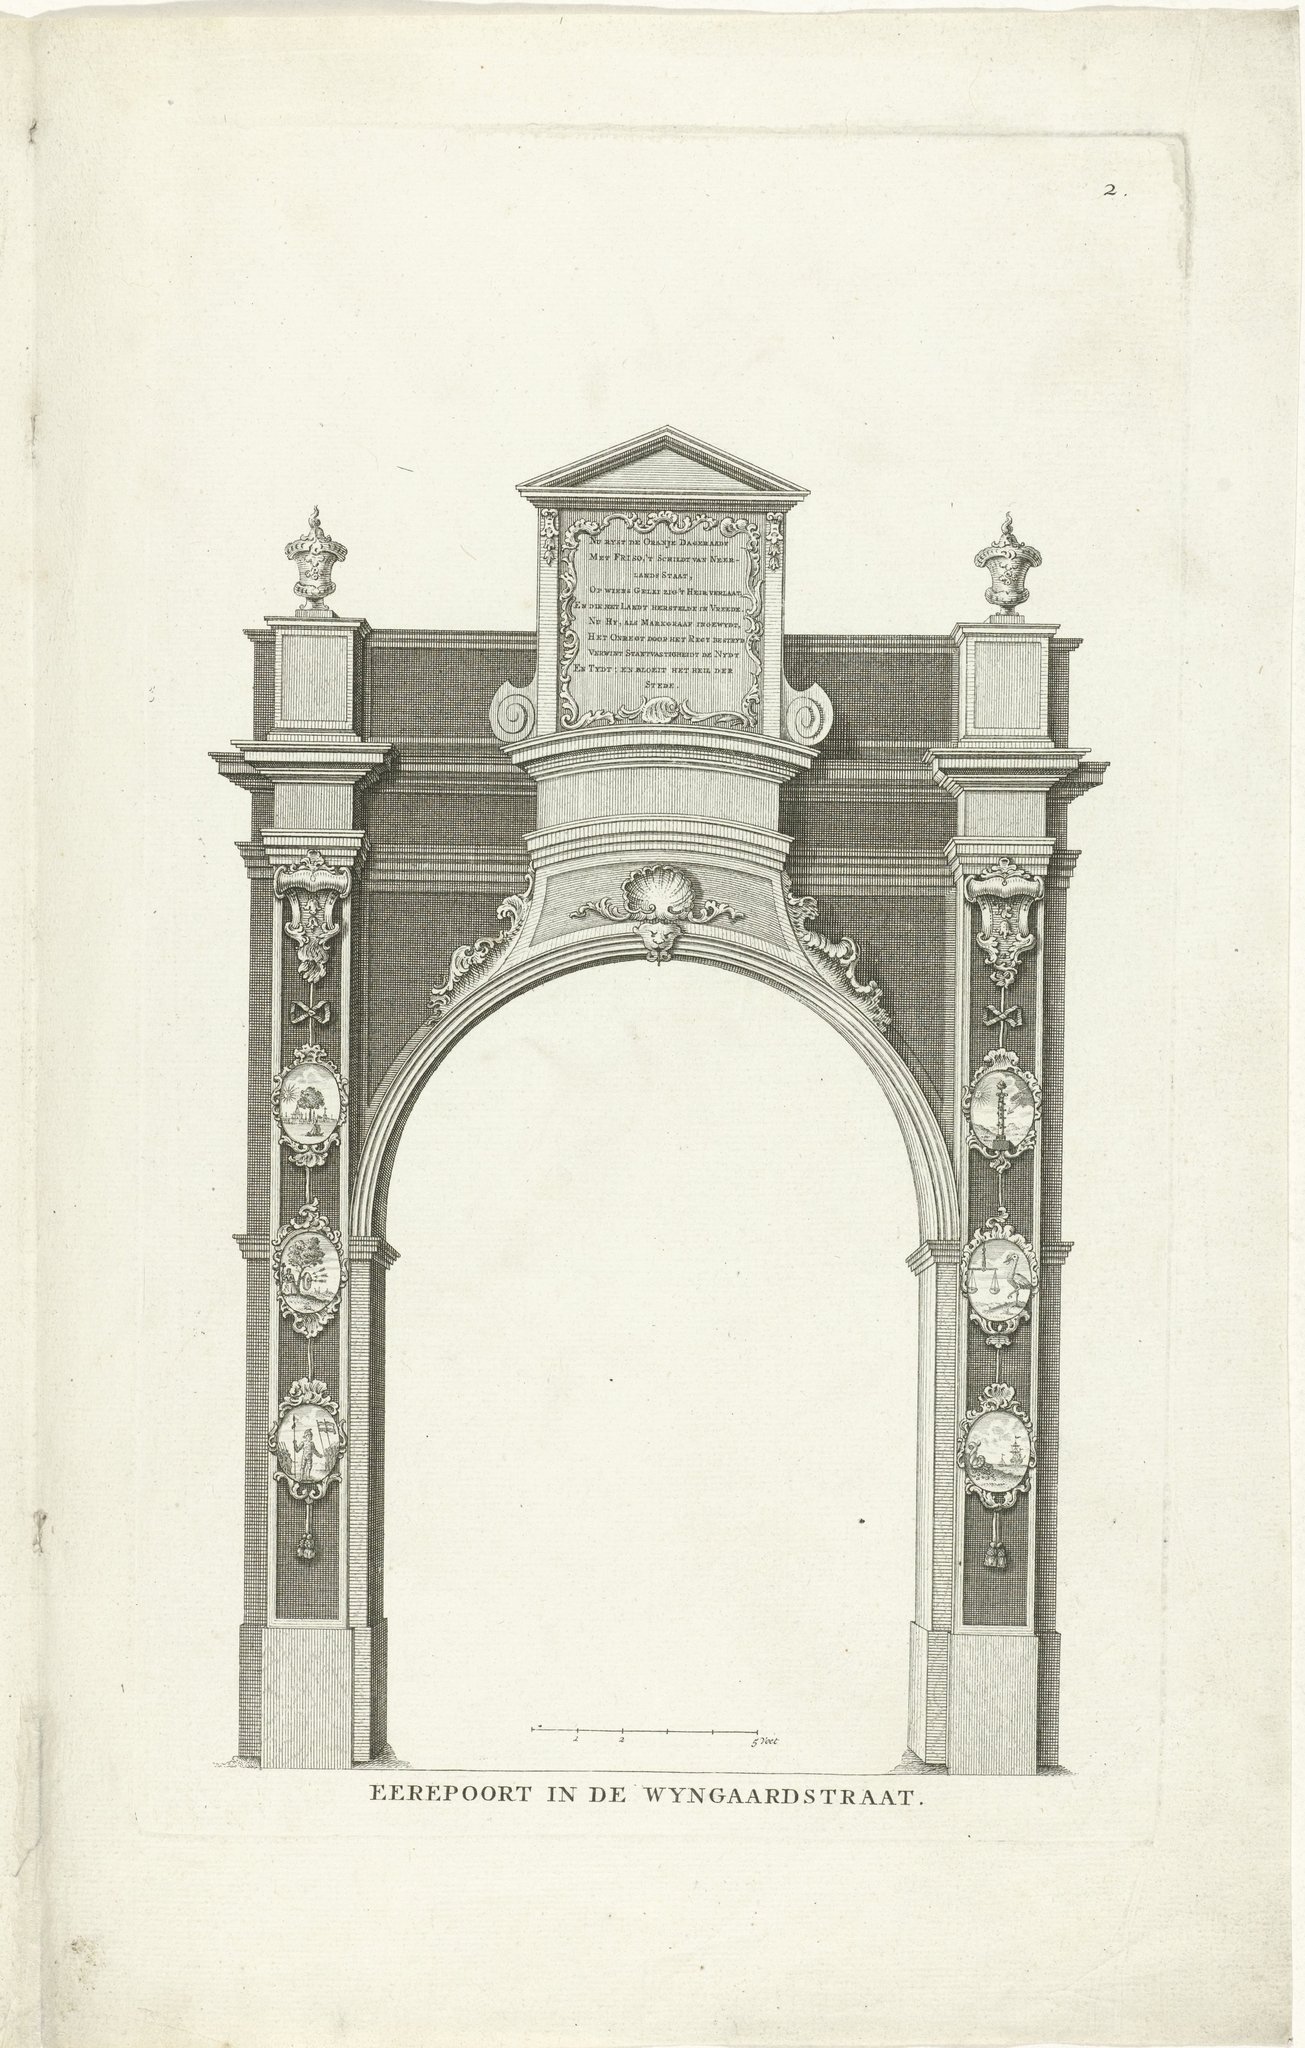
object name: print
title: Eerepoort in de Wyngaardstraat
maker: caspar jacobsz. philips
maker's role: draughtsman, print maker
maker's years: 1732-1789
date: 1751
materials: paper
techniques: etching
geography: veere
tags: the hague, willem iv (prins van oranje-nassau), triumphal arch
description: Dubbelgevouwen blad. Genummerd rechtsboven: 2. De erepoort geplaatst in de Wijngaardstraat. Onderdeel van de illustraties van de feestelijke inhuldiging van stadhouder Willem IV als markgraaf van Veere op 1 juni 1751.